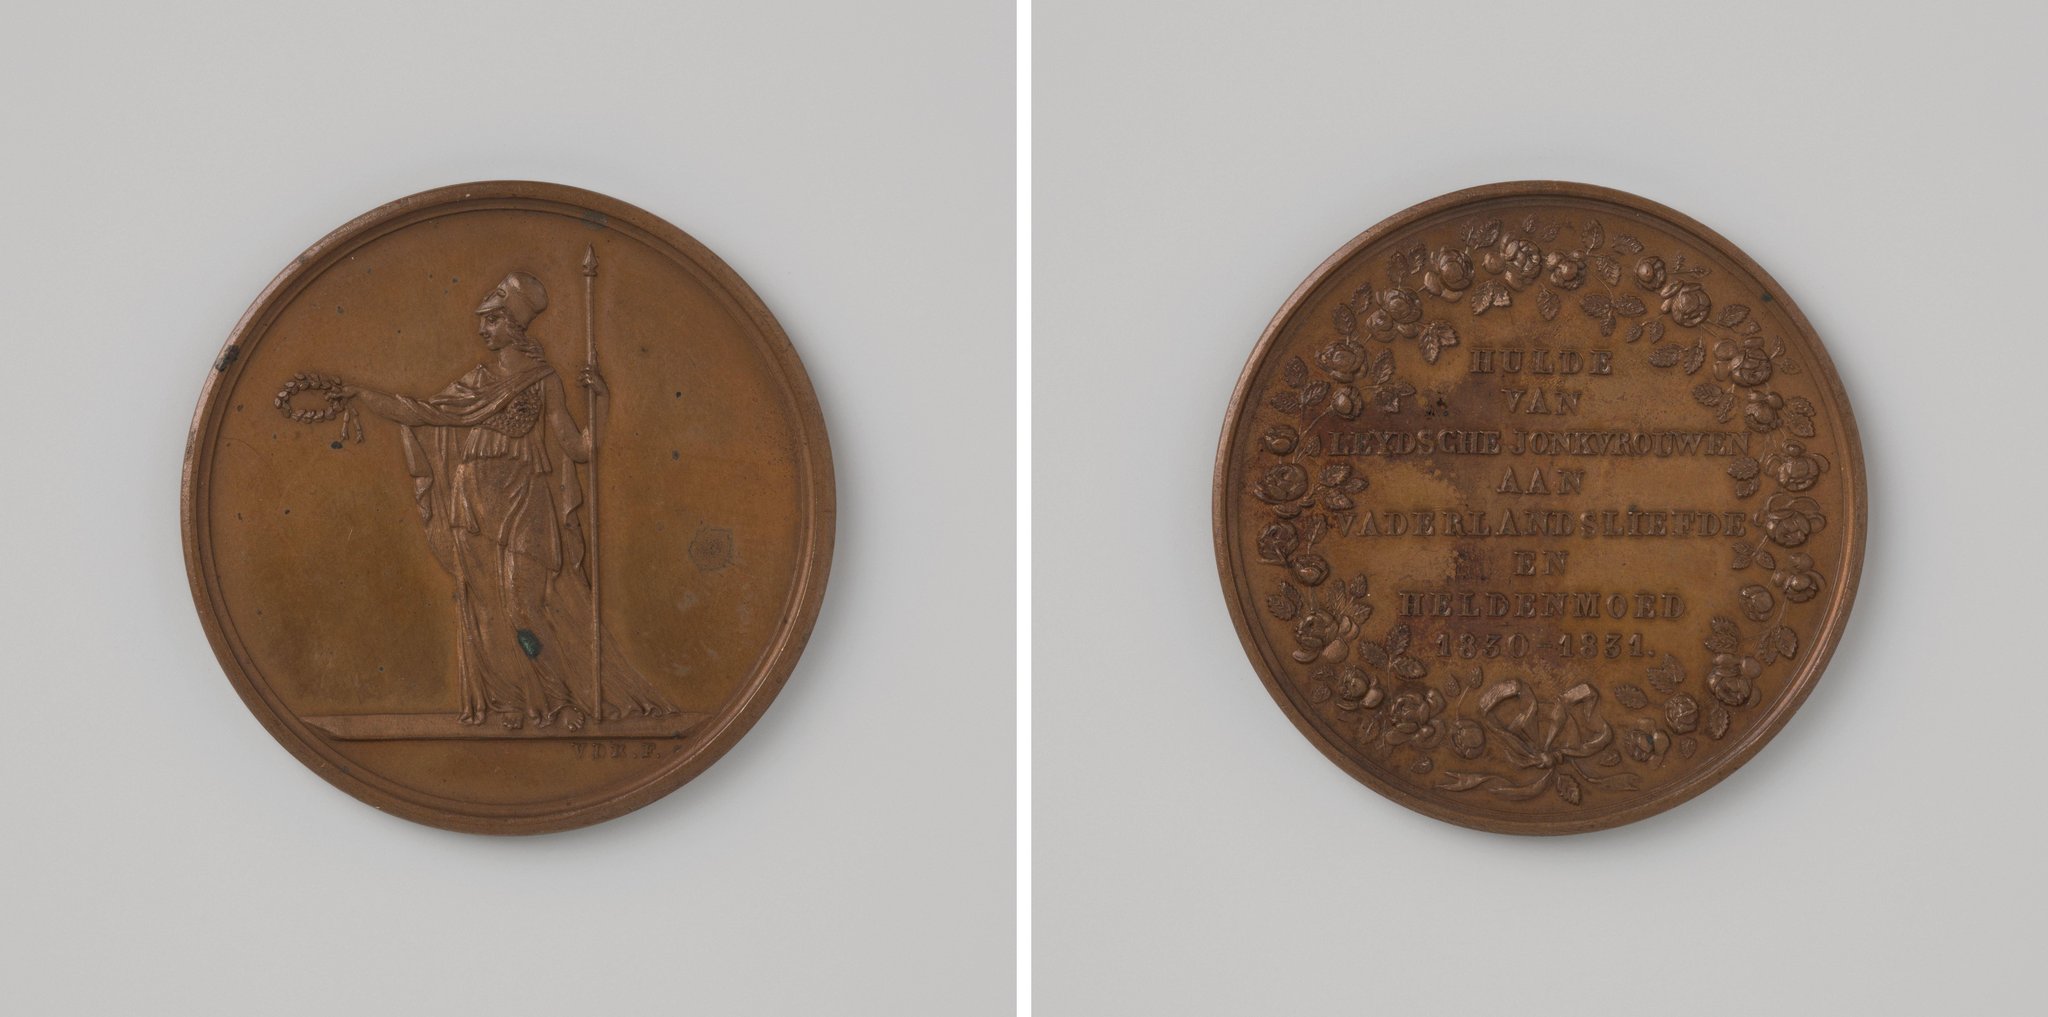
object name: history medal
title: Hulde van de Leidse jonkvrouwen aan de uitgetrokken studenten 1831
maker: david van der kellen (1804-1879)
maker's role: die cutter, draughtsman, print maker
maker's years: 1804-1879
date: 1831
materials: bronze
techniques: striking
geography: utrecht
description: Bronzen penning, op de voorzijde Minerva met lauwerkrans in de uitgestrekte hand, op de keerzijde acht regels tekst tussen samengestrikte rozentakken.